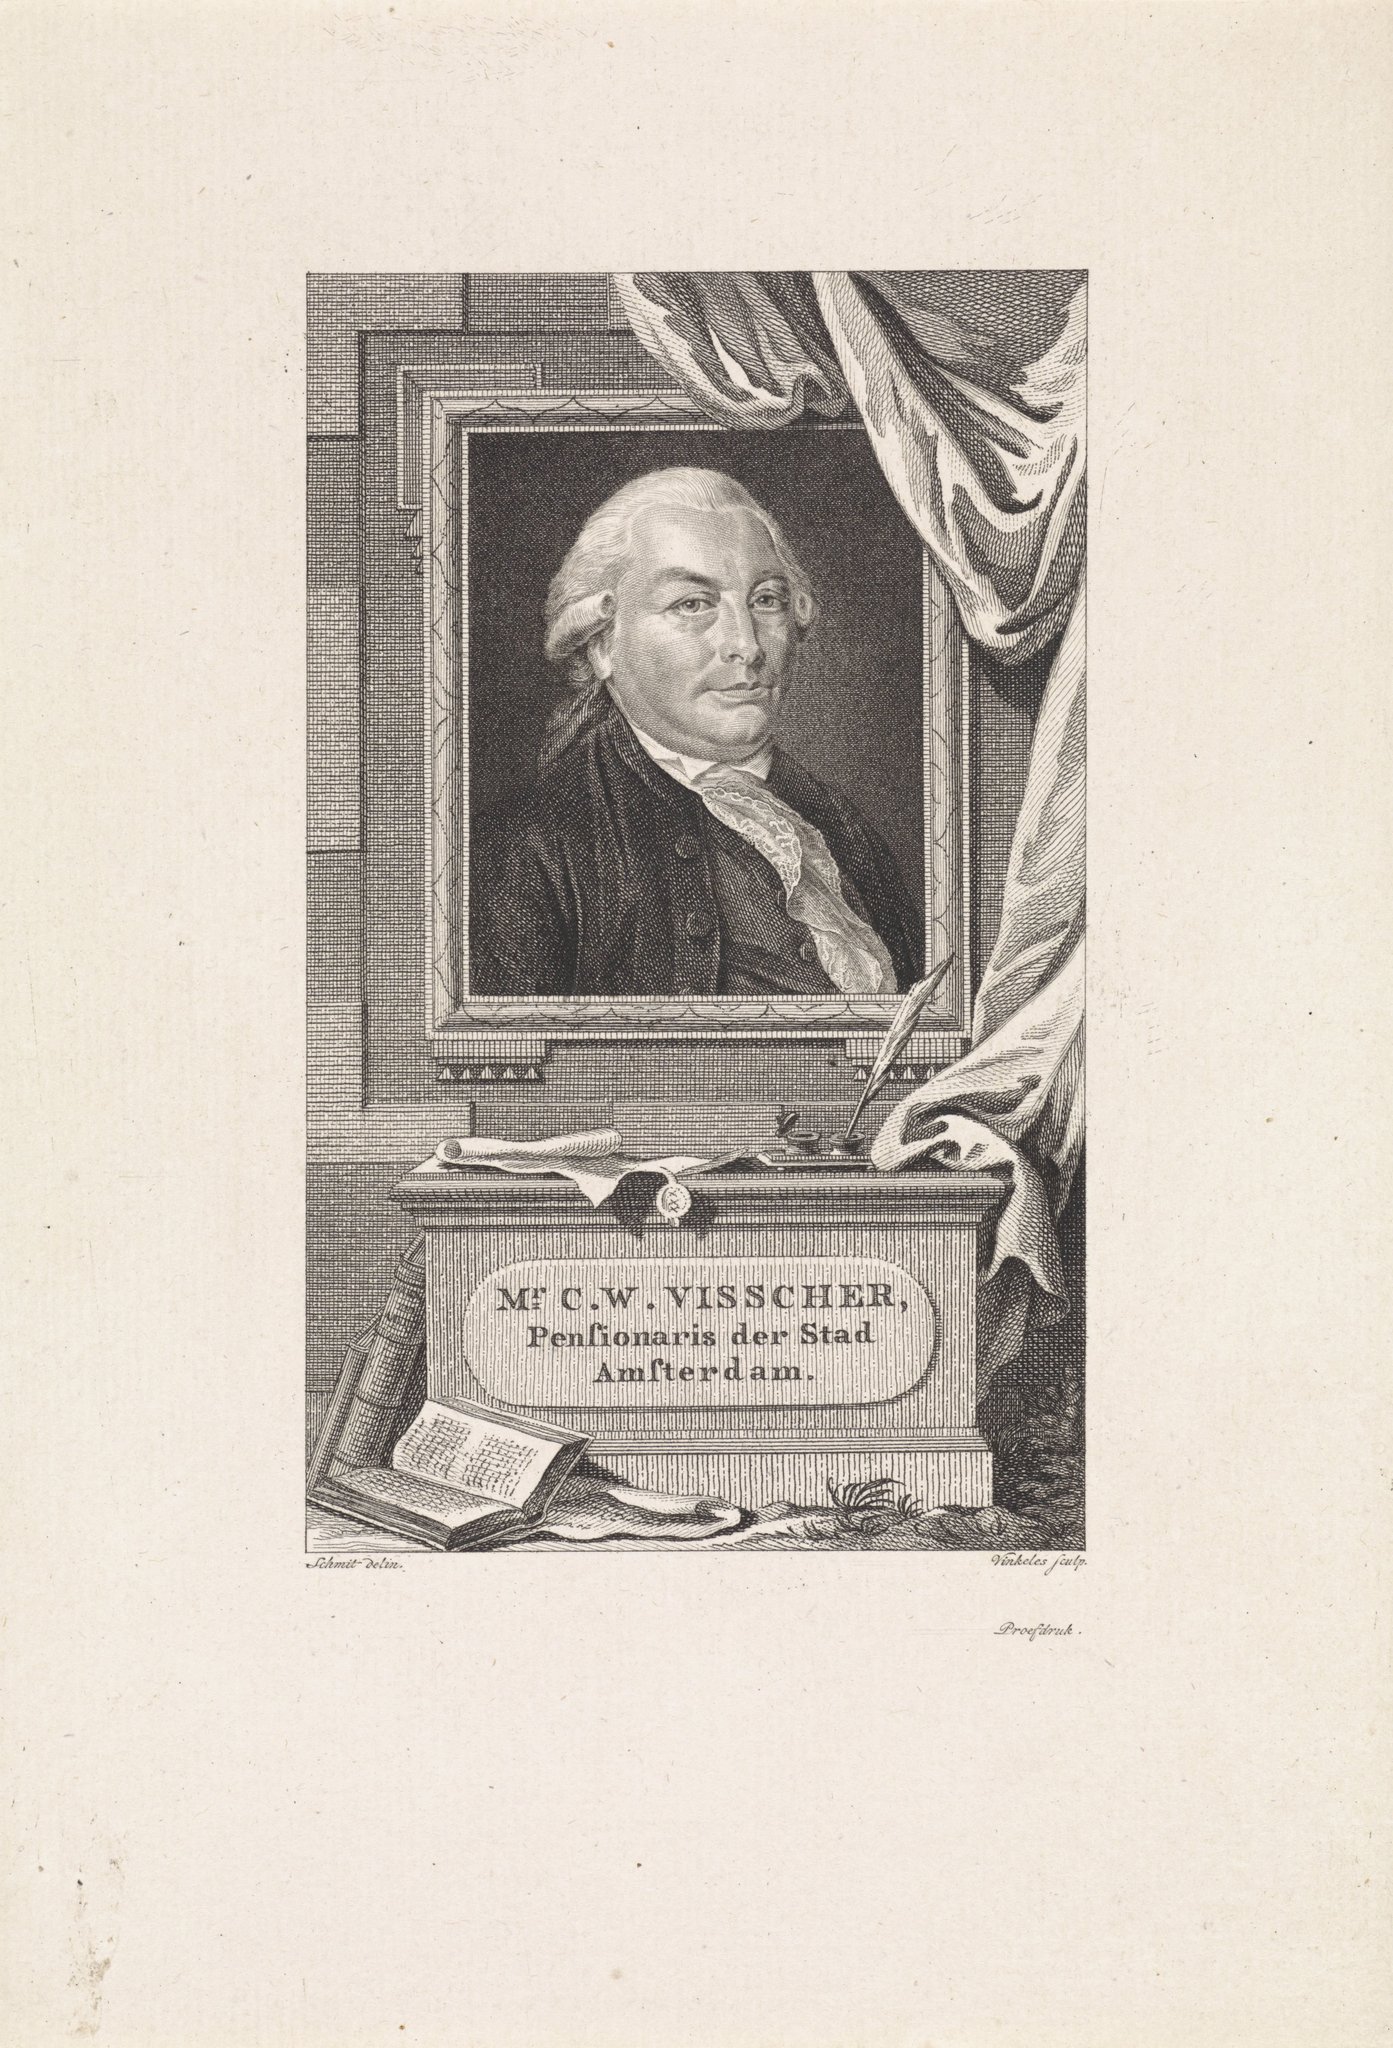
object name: print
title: Portret van Carel Wouter Visscher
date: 1786-1809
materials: paper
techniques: engraving, etching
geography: amsterdam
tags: advocaat, hoofdofficier, carel wouter visscher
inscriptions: collector's mark: Lugt 240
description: Latere staat prent ook gebruikt als boekillustratie in: Wagenaar, Jan. Vaderlandsche historie, (...) ten vervolge van Wagenaars Vaderlandsche historie. Dl. 1-43. Amsterdam: Johannes Allart, 1786-1809.